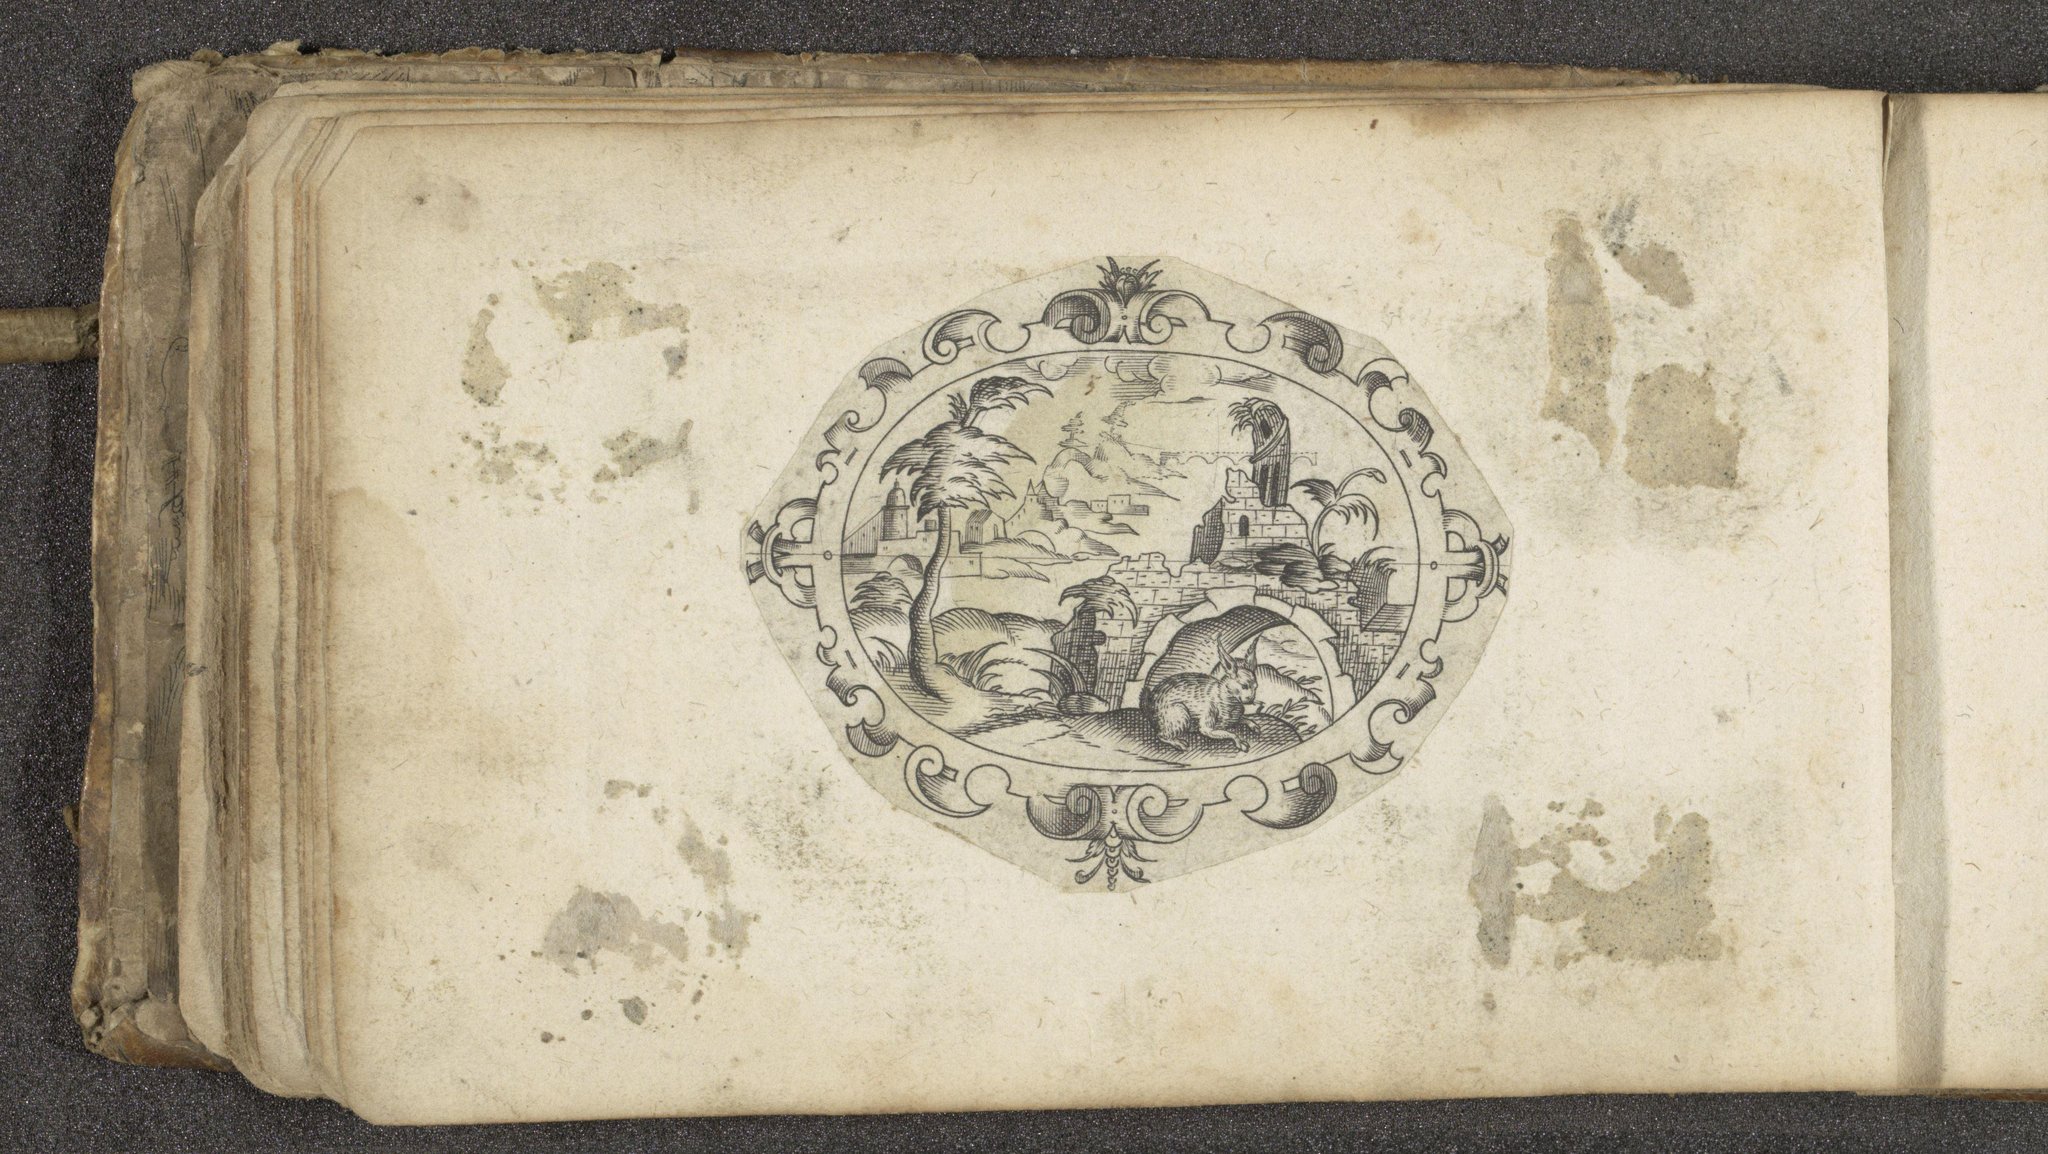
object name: print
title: Cartouche met een haas onder een brug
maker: georg hermann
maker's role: goldsmith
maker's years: 1579-1603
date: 1595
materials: paper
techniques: engraving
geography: ansbach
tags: rodents: hare, landscape with bridge, viaduct or aqueduct, ornament ~ cartouche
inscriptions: inscription: ‘5’, inscription: ‘42’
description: Rolwerk cartouche met een landschap waarin een haas onder de ruïne van een brug zit. De prent maakt deel uit van een album.